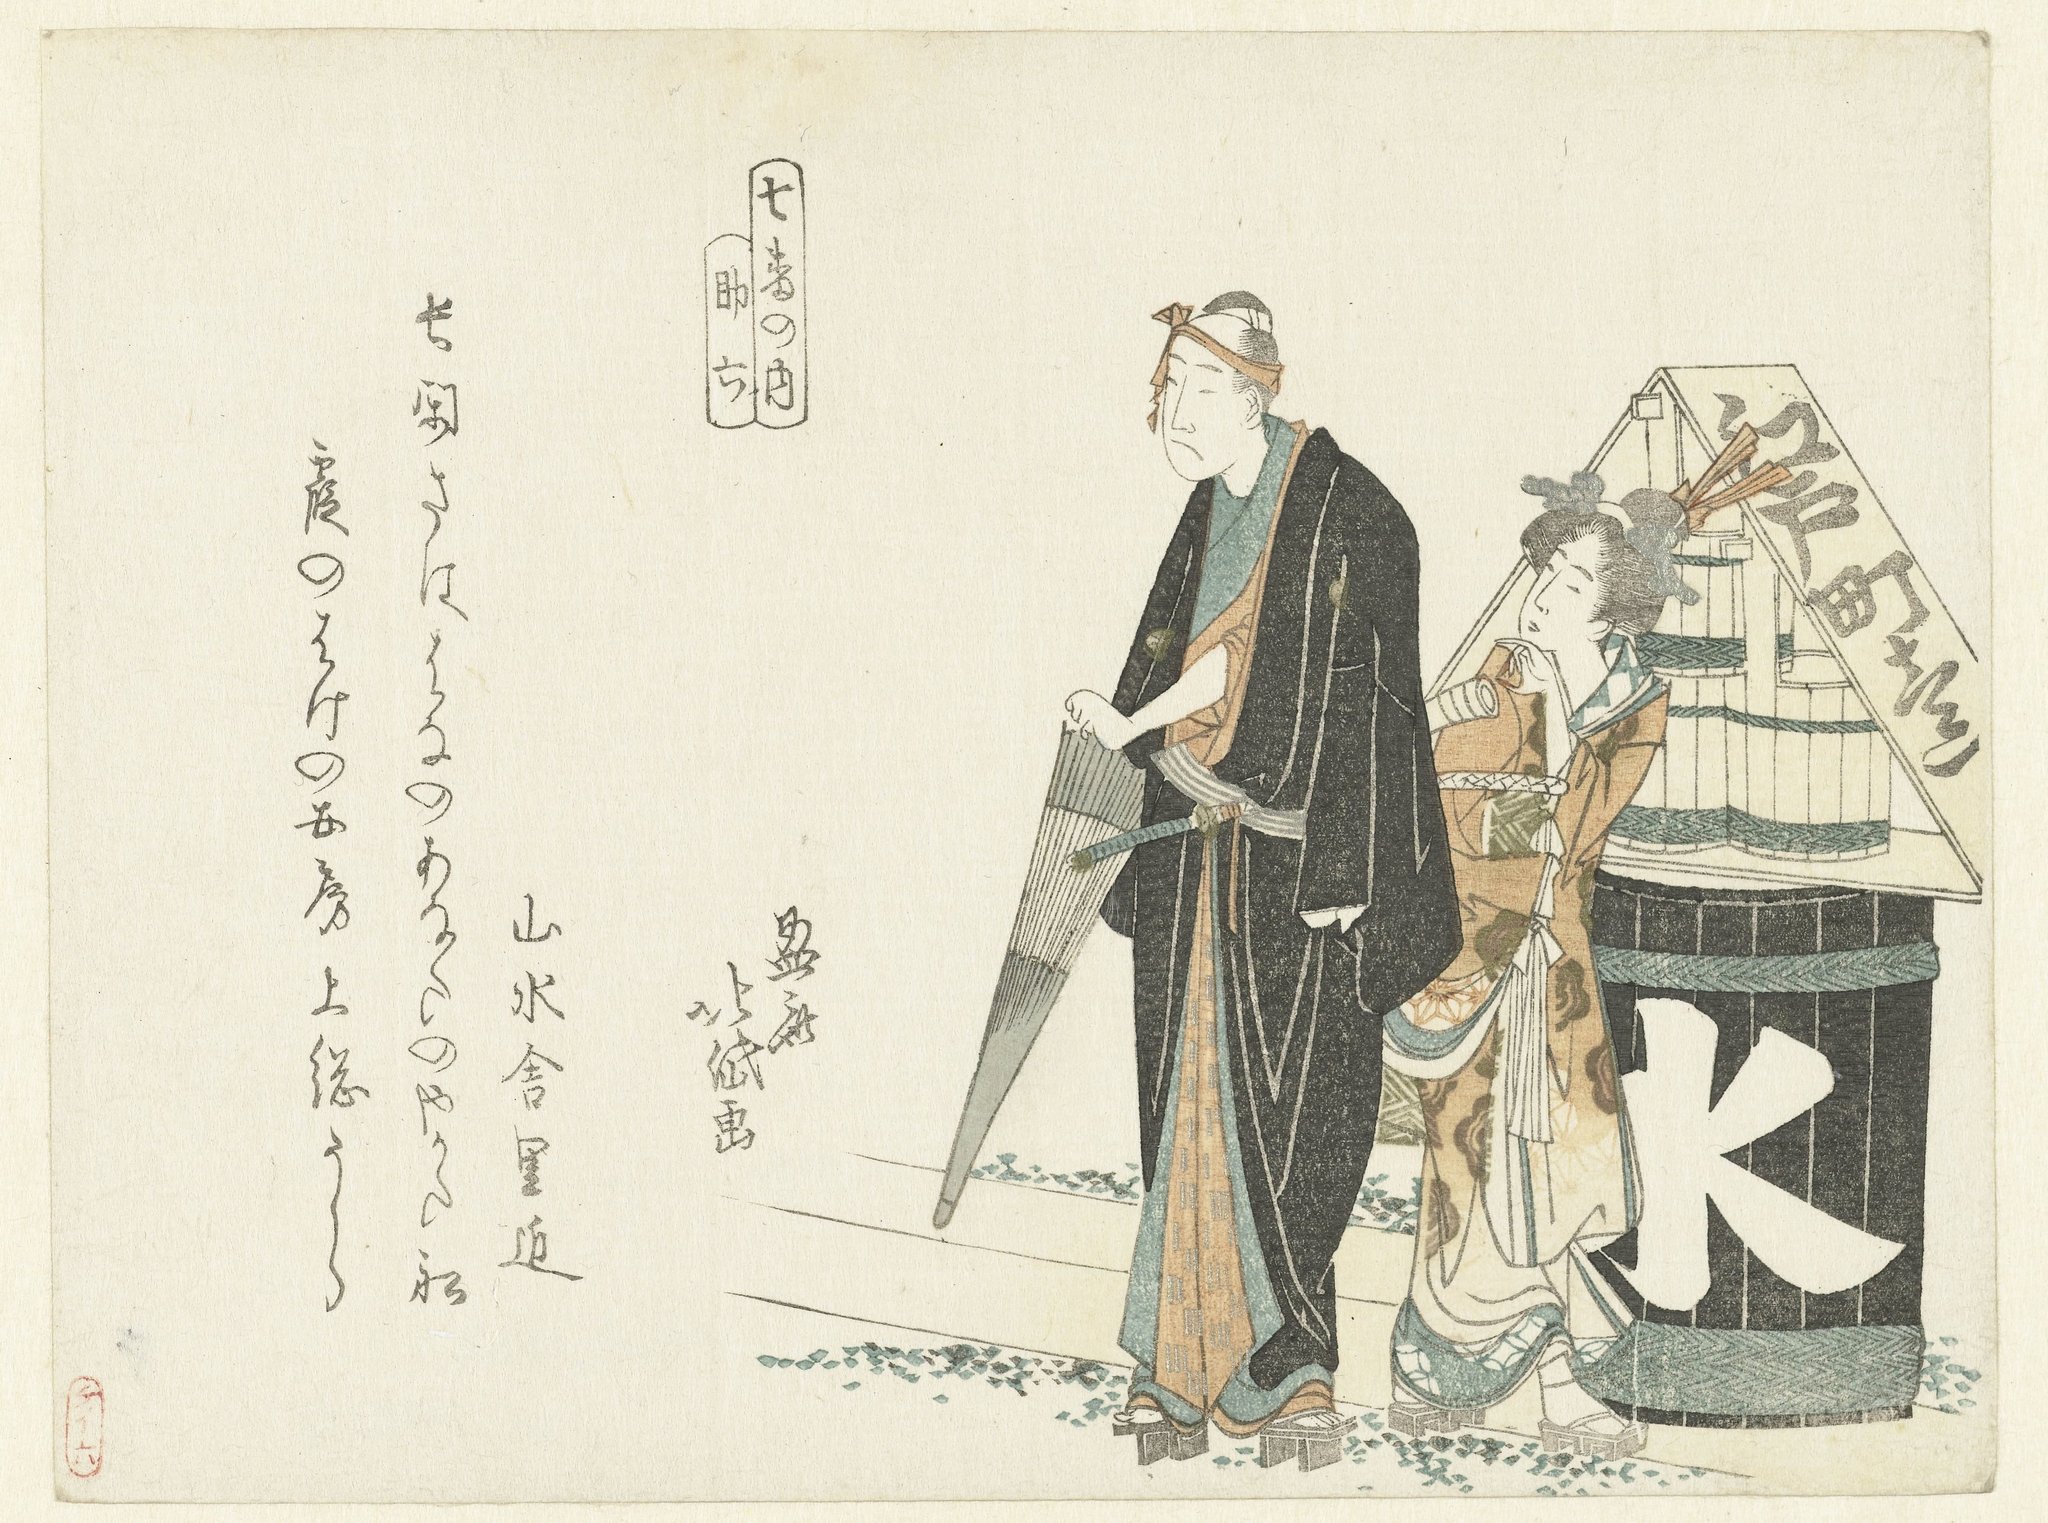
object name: surimono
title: Man with Umbrella by a Water Barrel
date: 1800-1805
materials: paper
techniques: woodcut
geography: japan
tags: actor, actress (non-work situations)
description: Een surimono is een luxe uitgevoerde prent waarop beeld met één of meerdere gedichten gecombineerd is. Bij het drukken van een surimono werd vaak gebruik gemaakt van dikker papier, blinddruk en metaal pigmenten, zoals koper- en zilverpoeder. De prenten werden vaak in opdracht van dichters gemaakt en als exclusief geschenk aan vrienden en relaties gegeven.